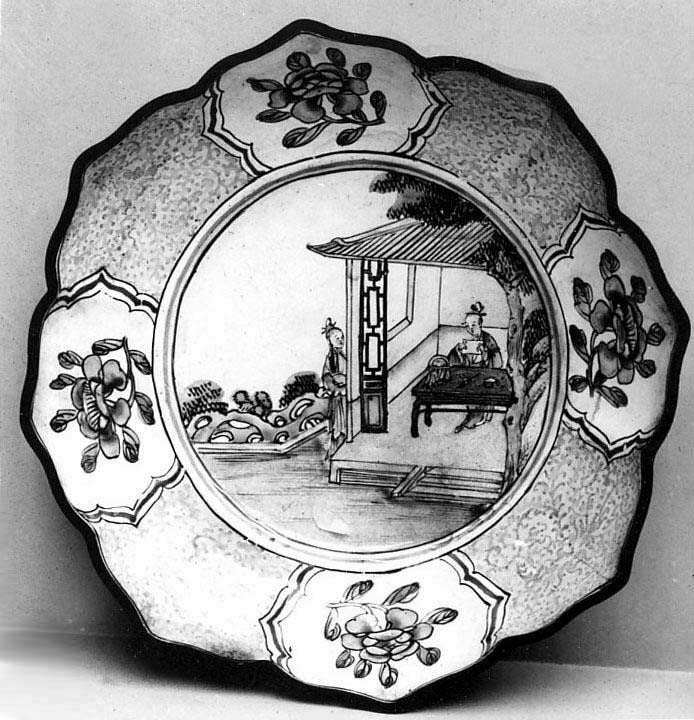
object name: dish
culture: chinese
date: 1801-1900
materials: enamel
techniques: painting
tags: human figures,houses,flowers